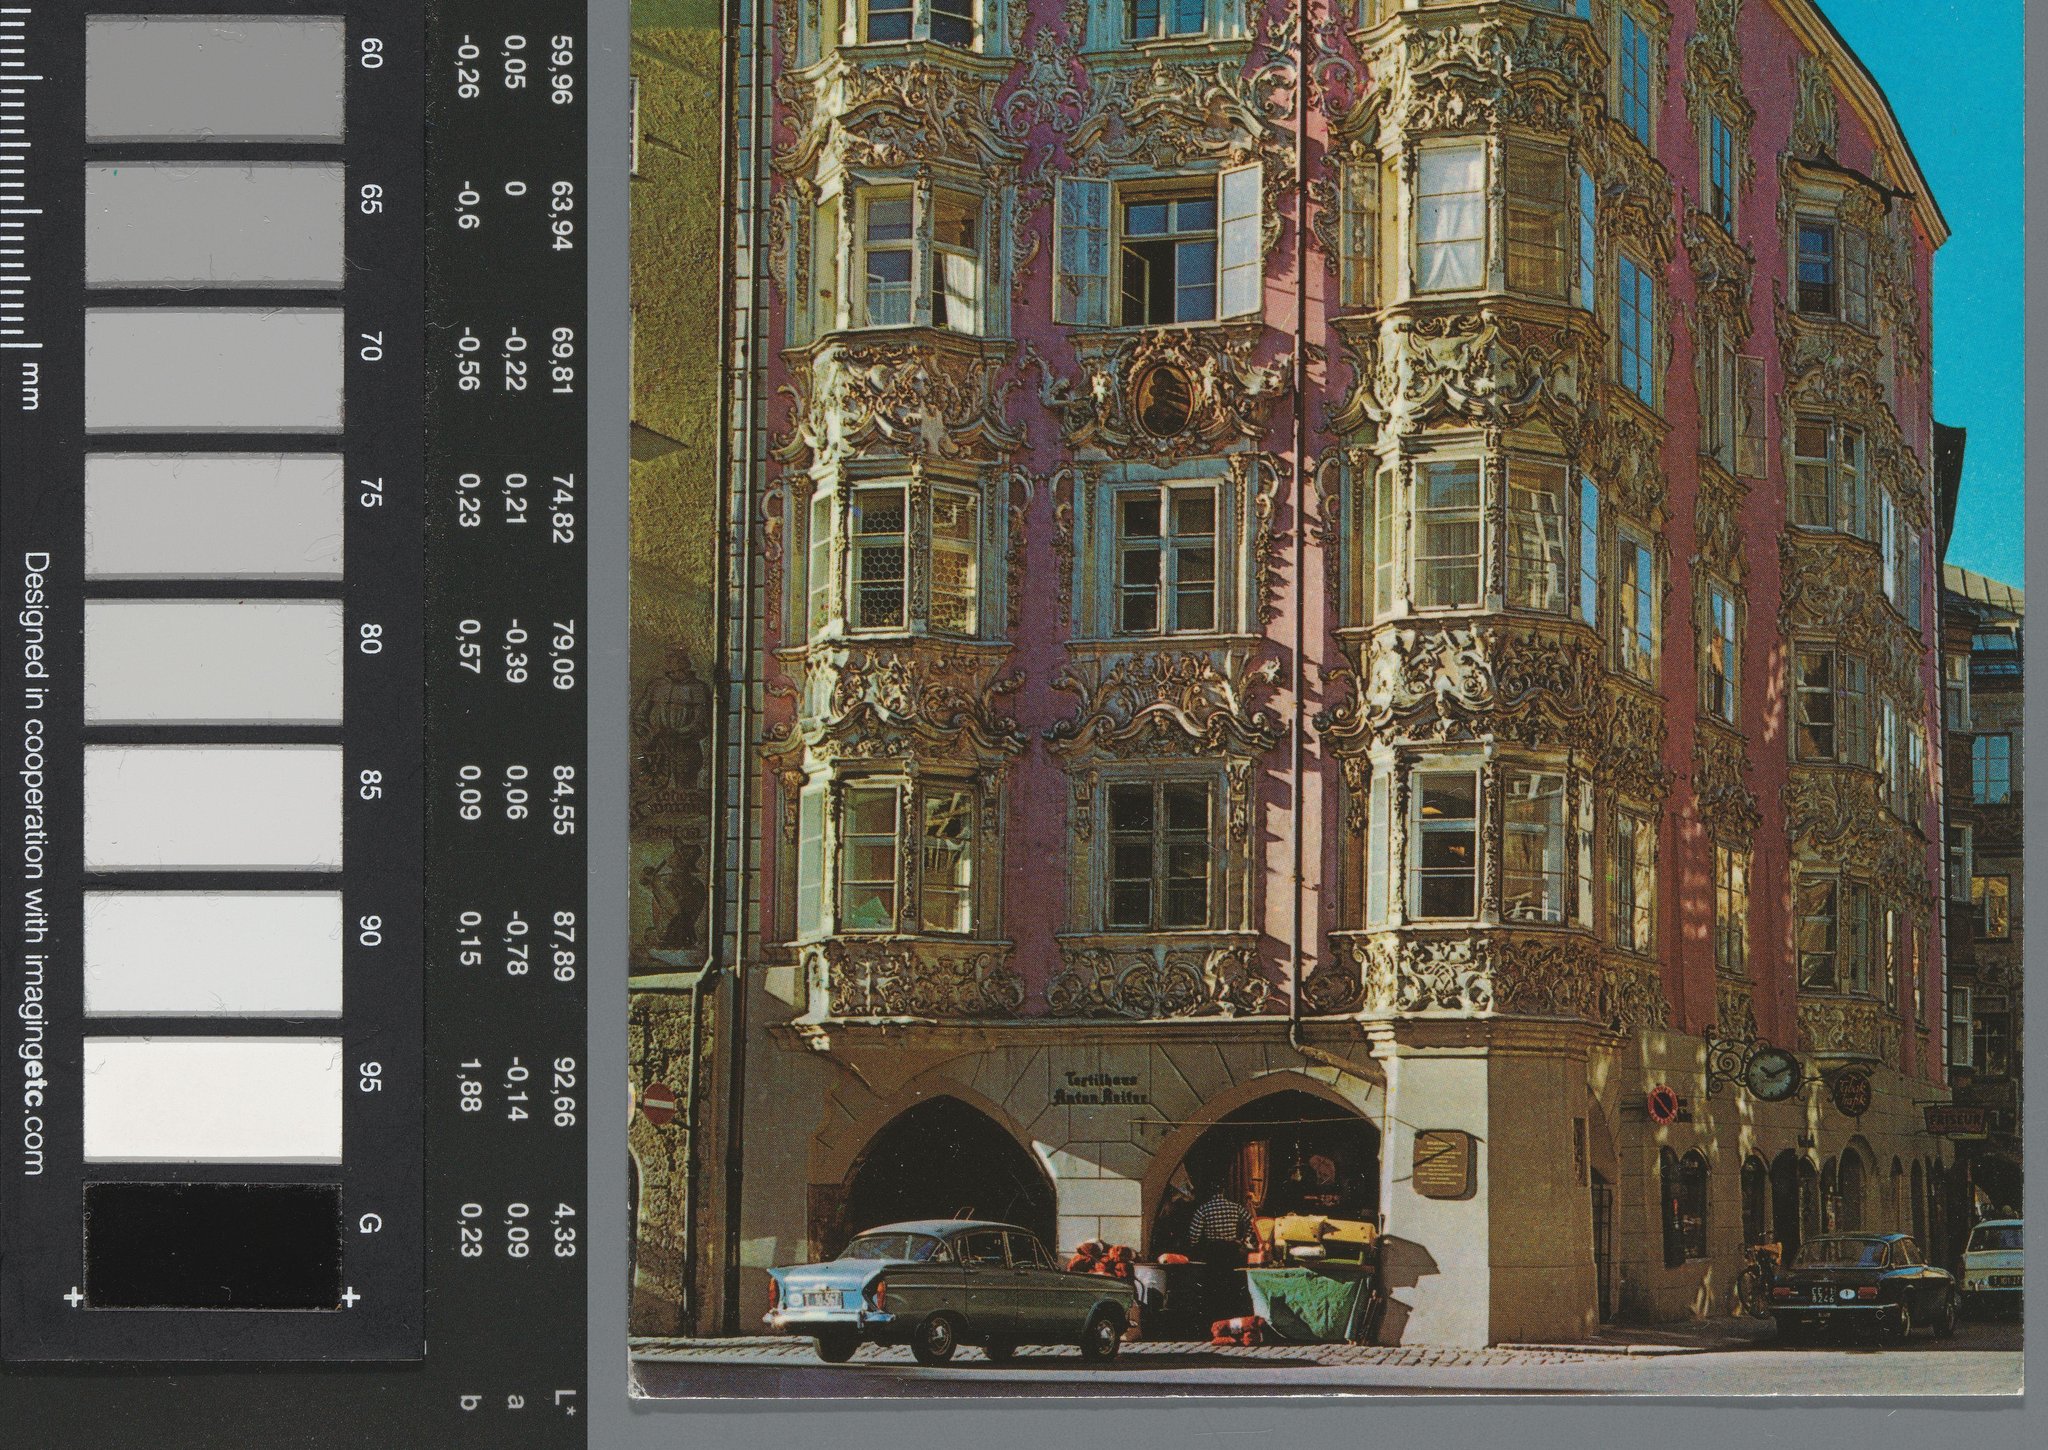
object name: postcard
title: Helblinghaus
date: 1920-1950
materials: photographic support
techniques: offset printed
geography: innsbruck